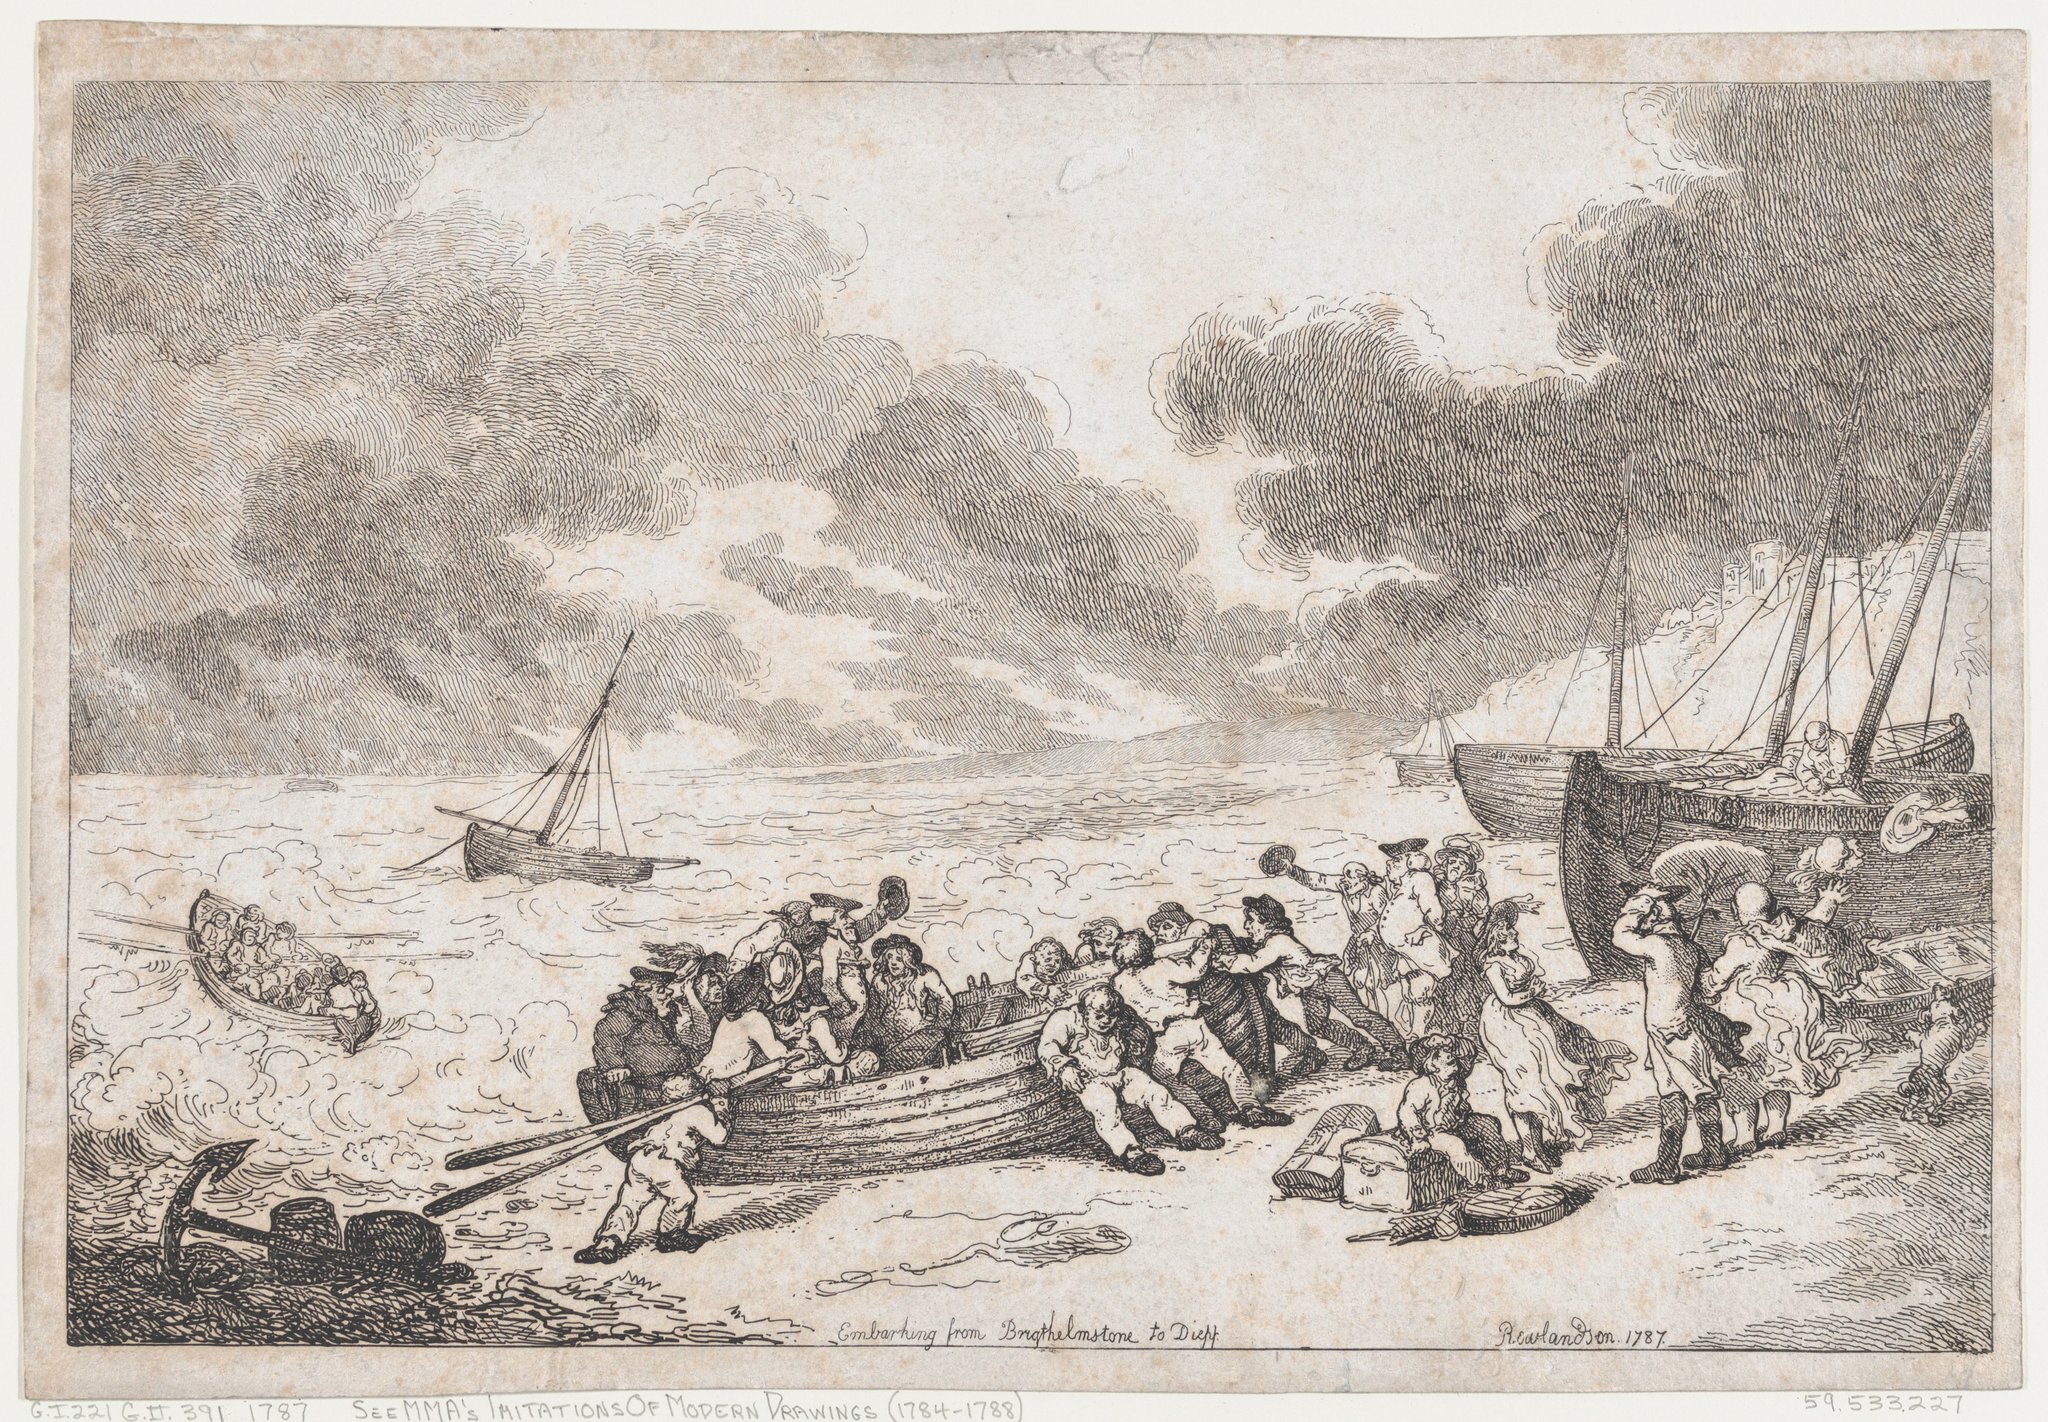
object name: print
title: Embarking from Brighthelmstone to Diepp[e]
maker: thomas rowlandson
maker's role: artist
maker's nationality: british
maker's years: 1757-1827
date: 1787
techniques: etching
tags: men,women,boats